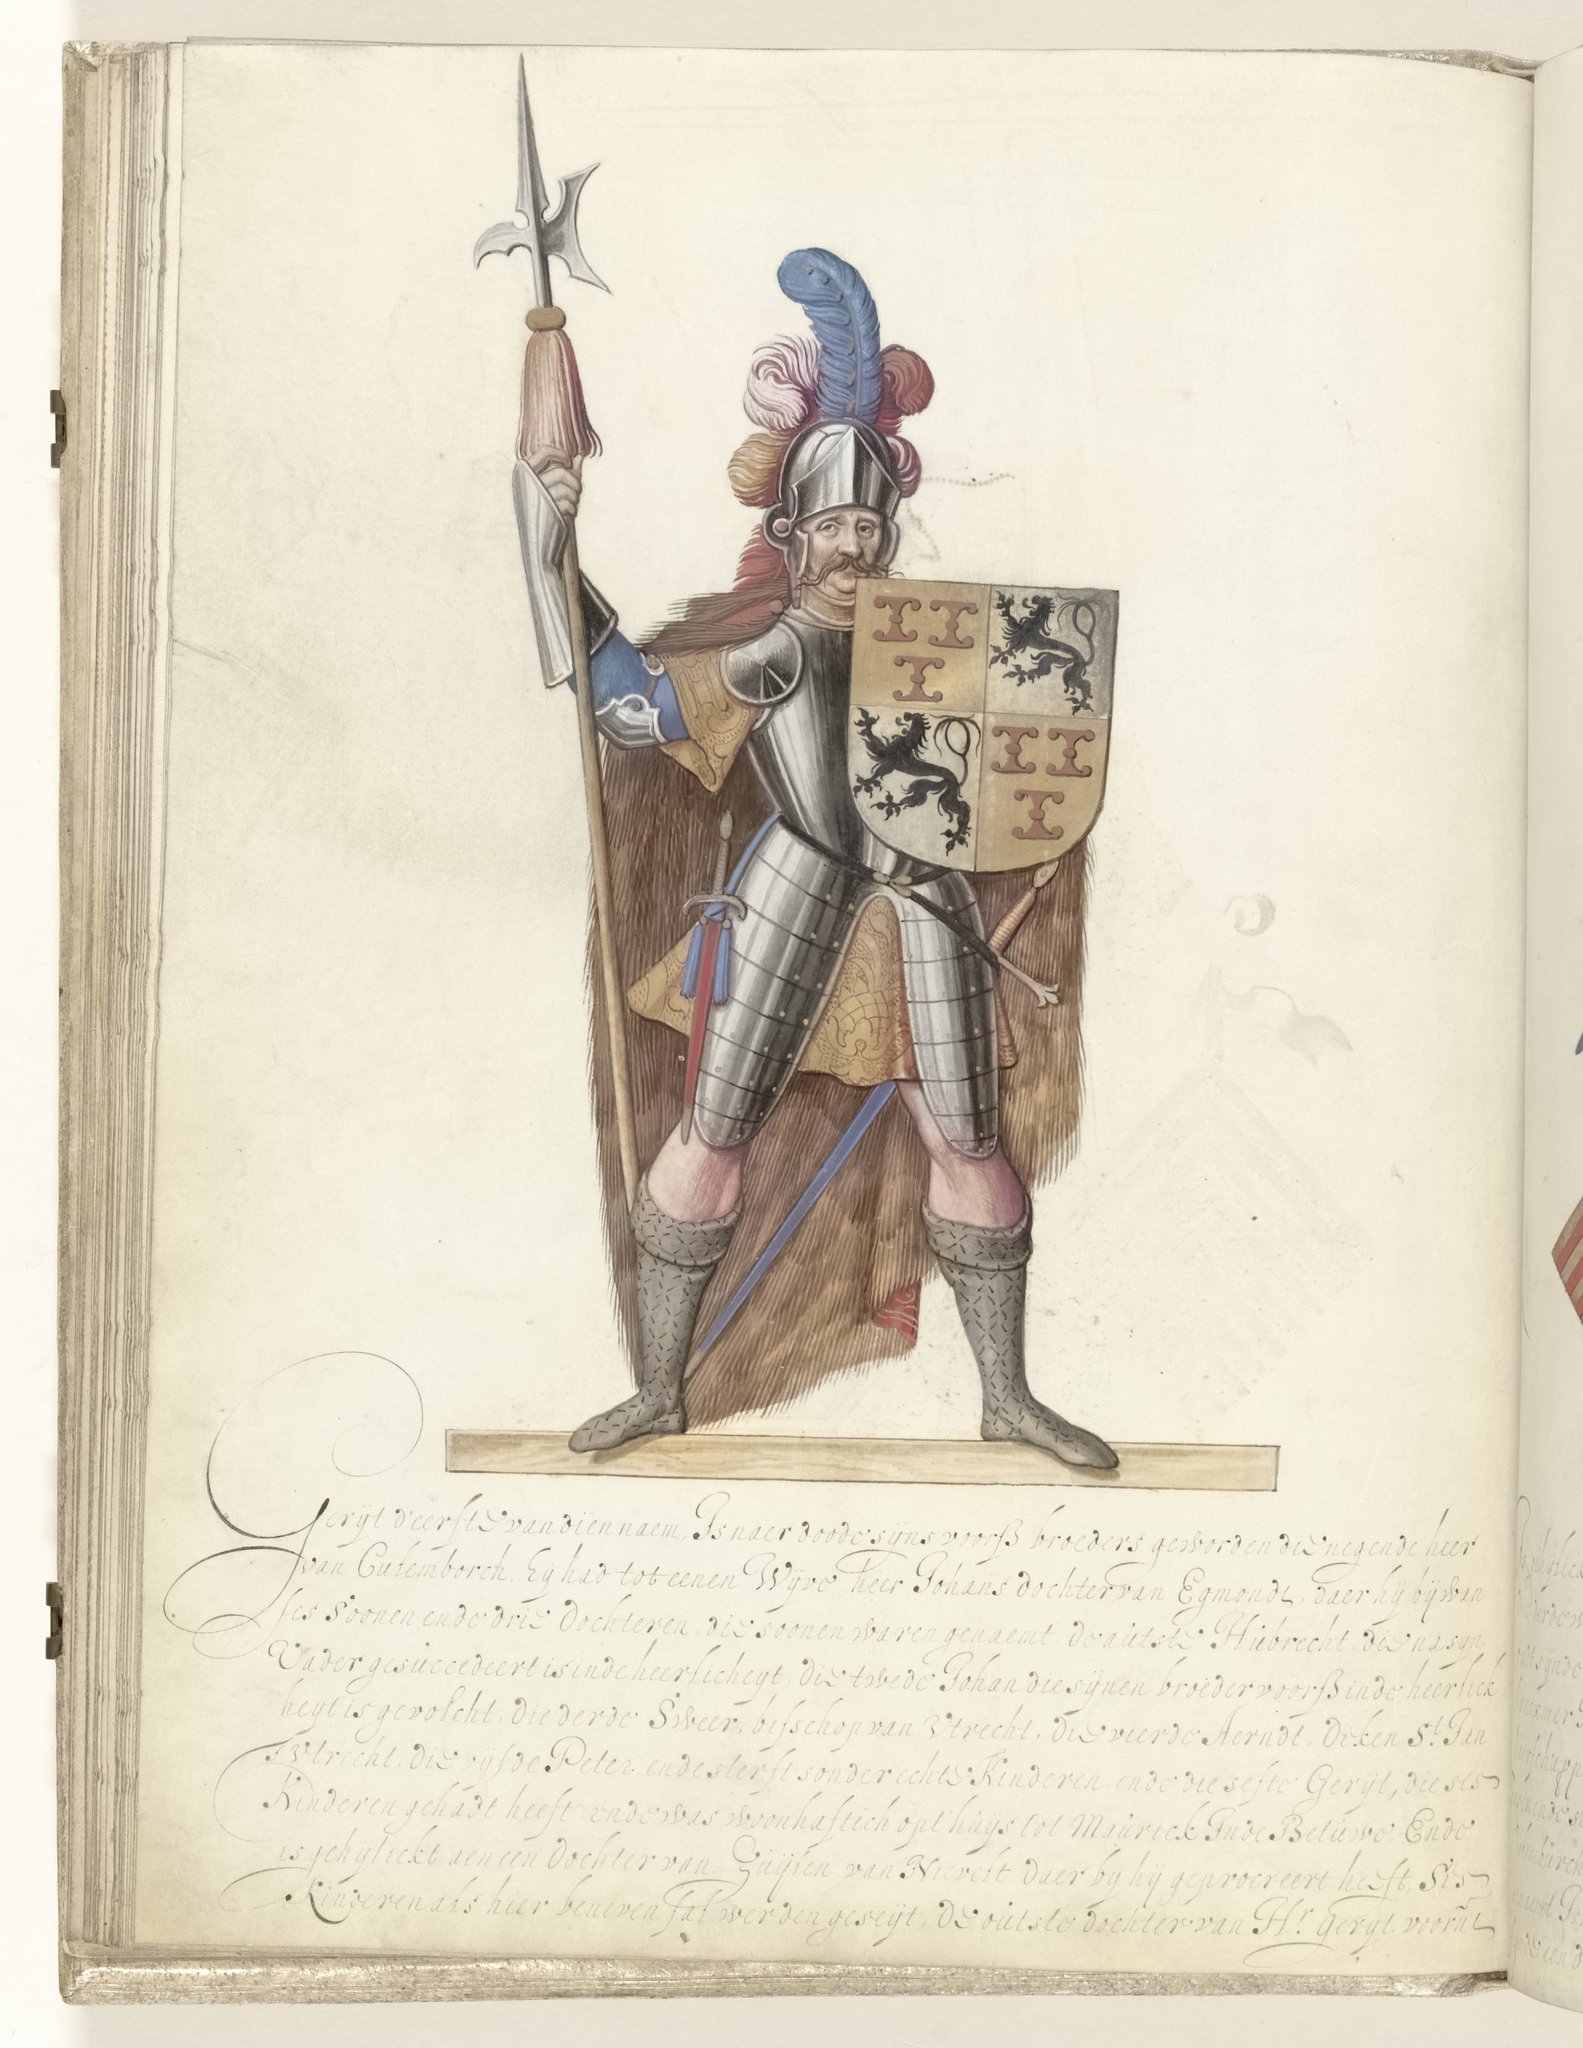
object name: drawing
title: Gerrit I, heer van Culemborg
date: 1590-1593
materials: paint, gouache, ink, parchment, watercolor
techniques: writing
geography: northern netherlands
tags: culemborg, heren en graven van, gerrit heer van culemborg (i), culemborg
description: Gerrit I, negende heer van Culemborg. Staande ten voeten uit in wapenrusting met hellebaard in de rechterhand en het gevierendeelde wapen van Culemborg en van de Leck in de linkerhand. Onderdeel van een geïllustreerd handschrift met de genealogie van de heren en graven van Culemborg.